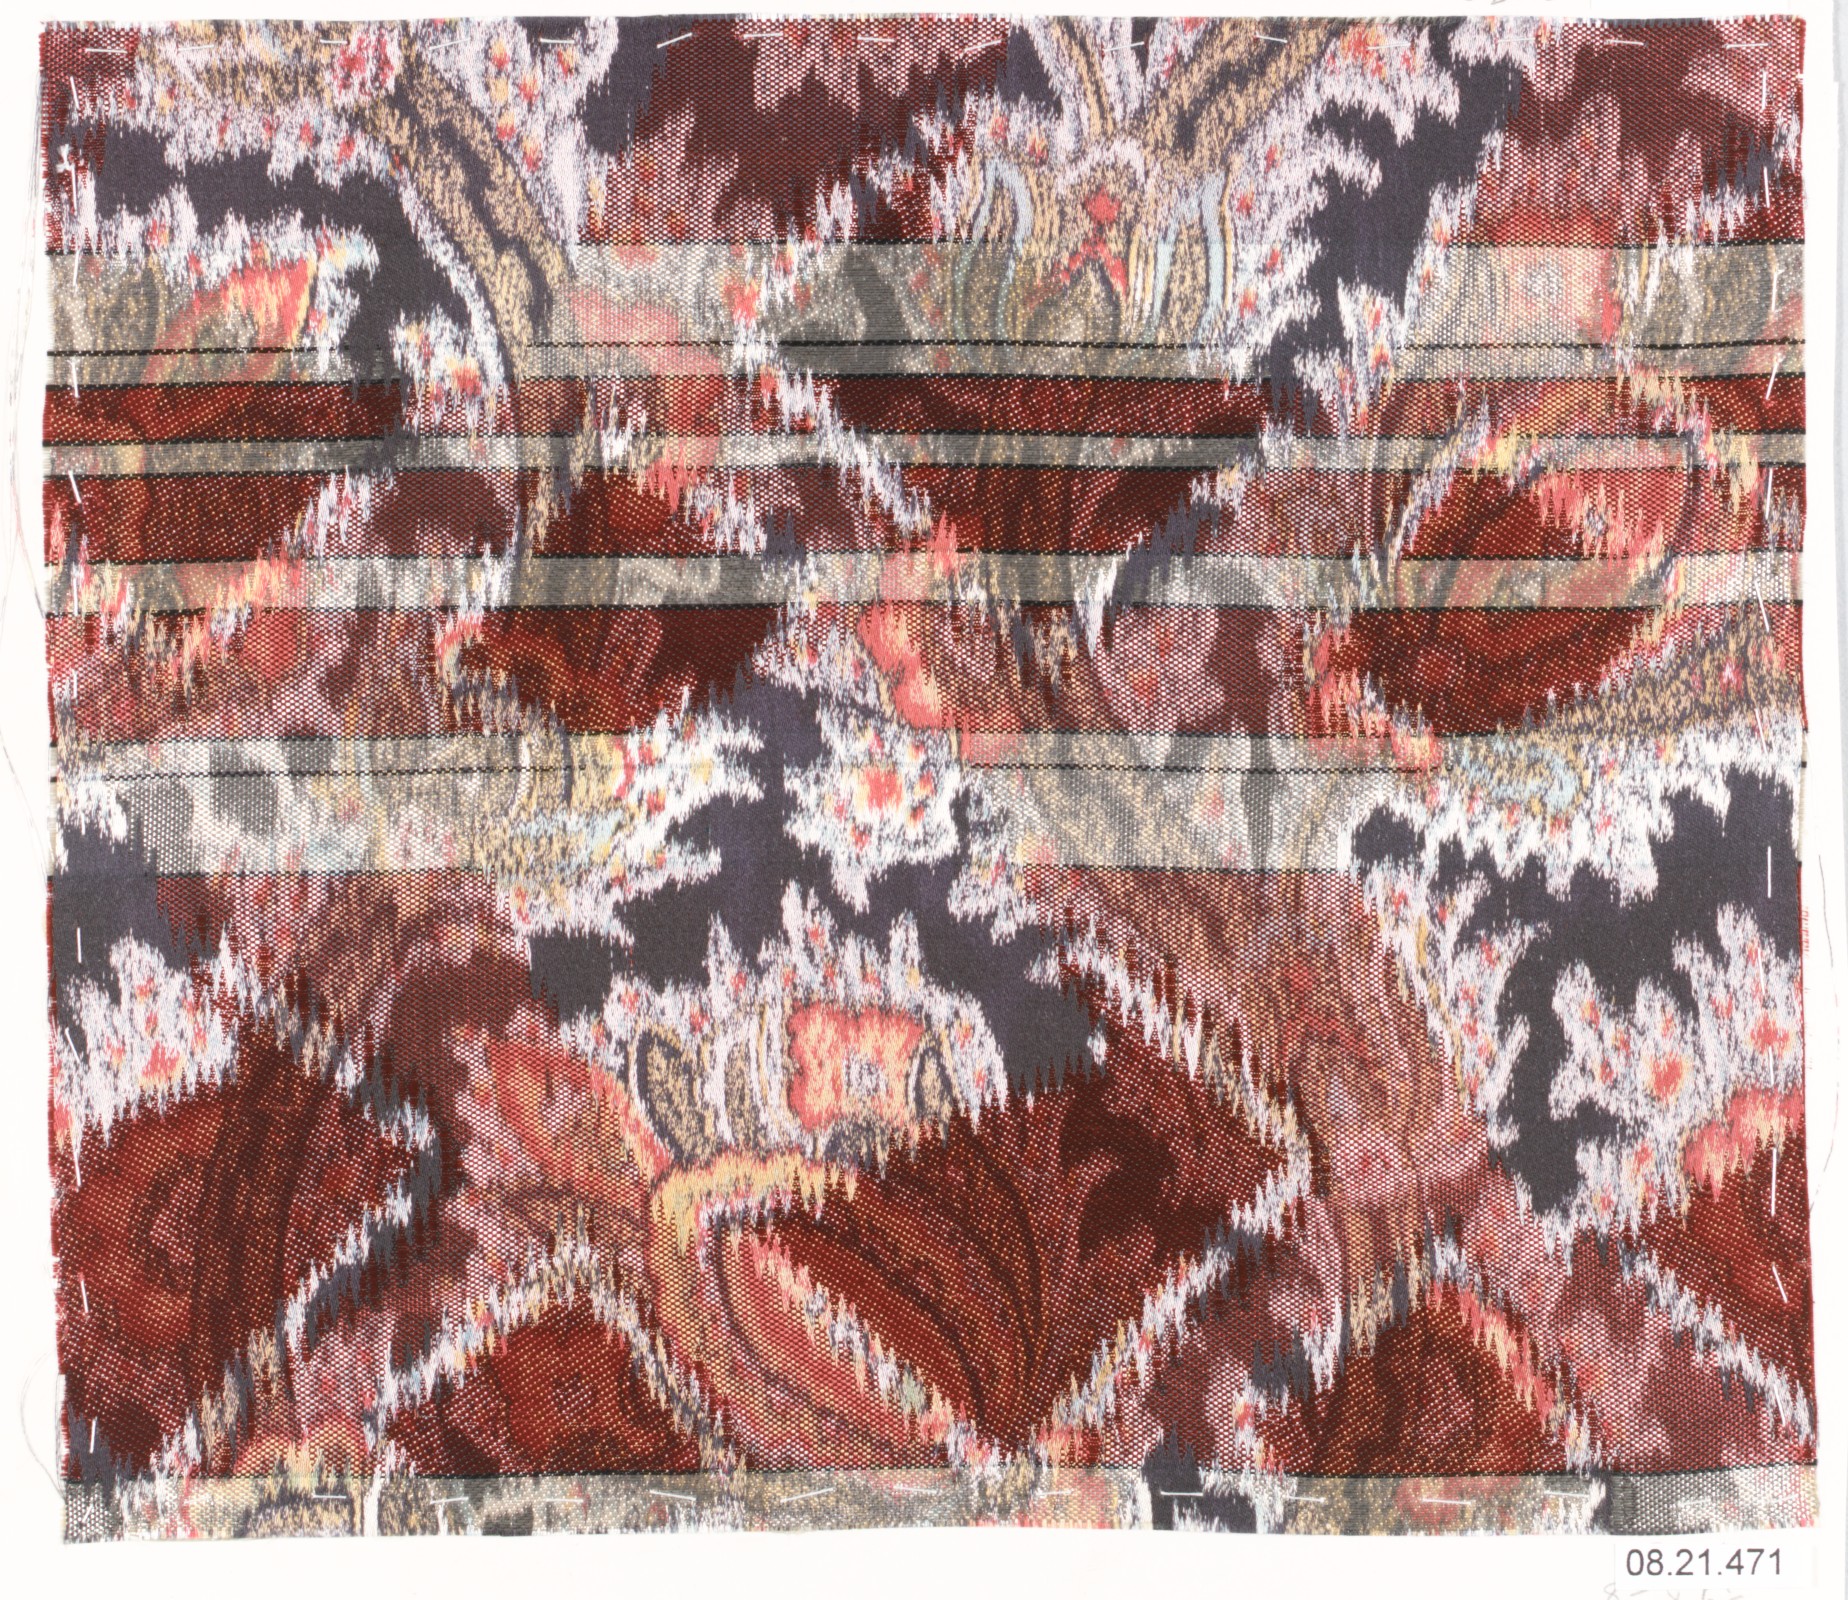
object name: textile sample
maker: Anonymous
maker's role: designer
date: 1900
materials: silk